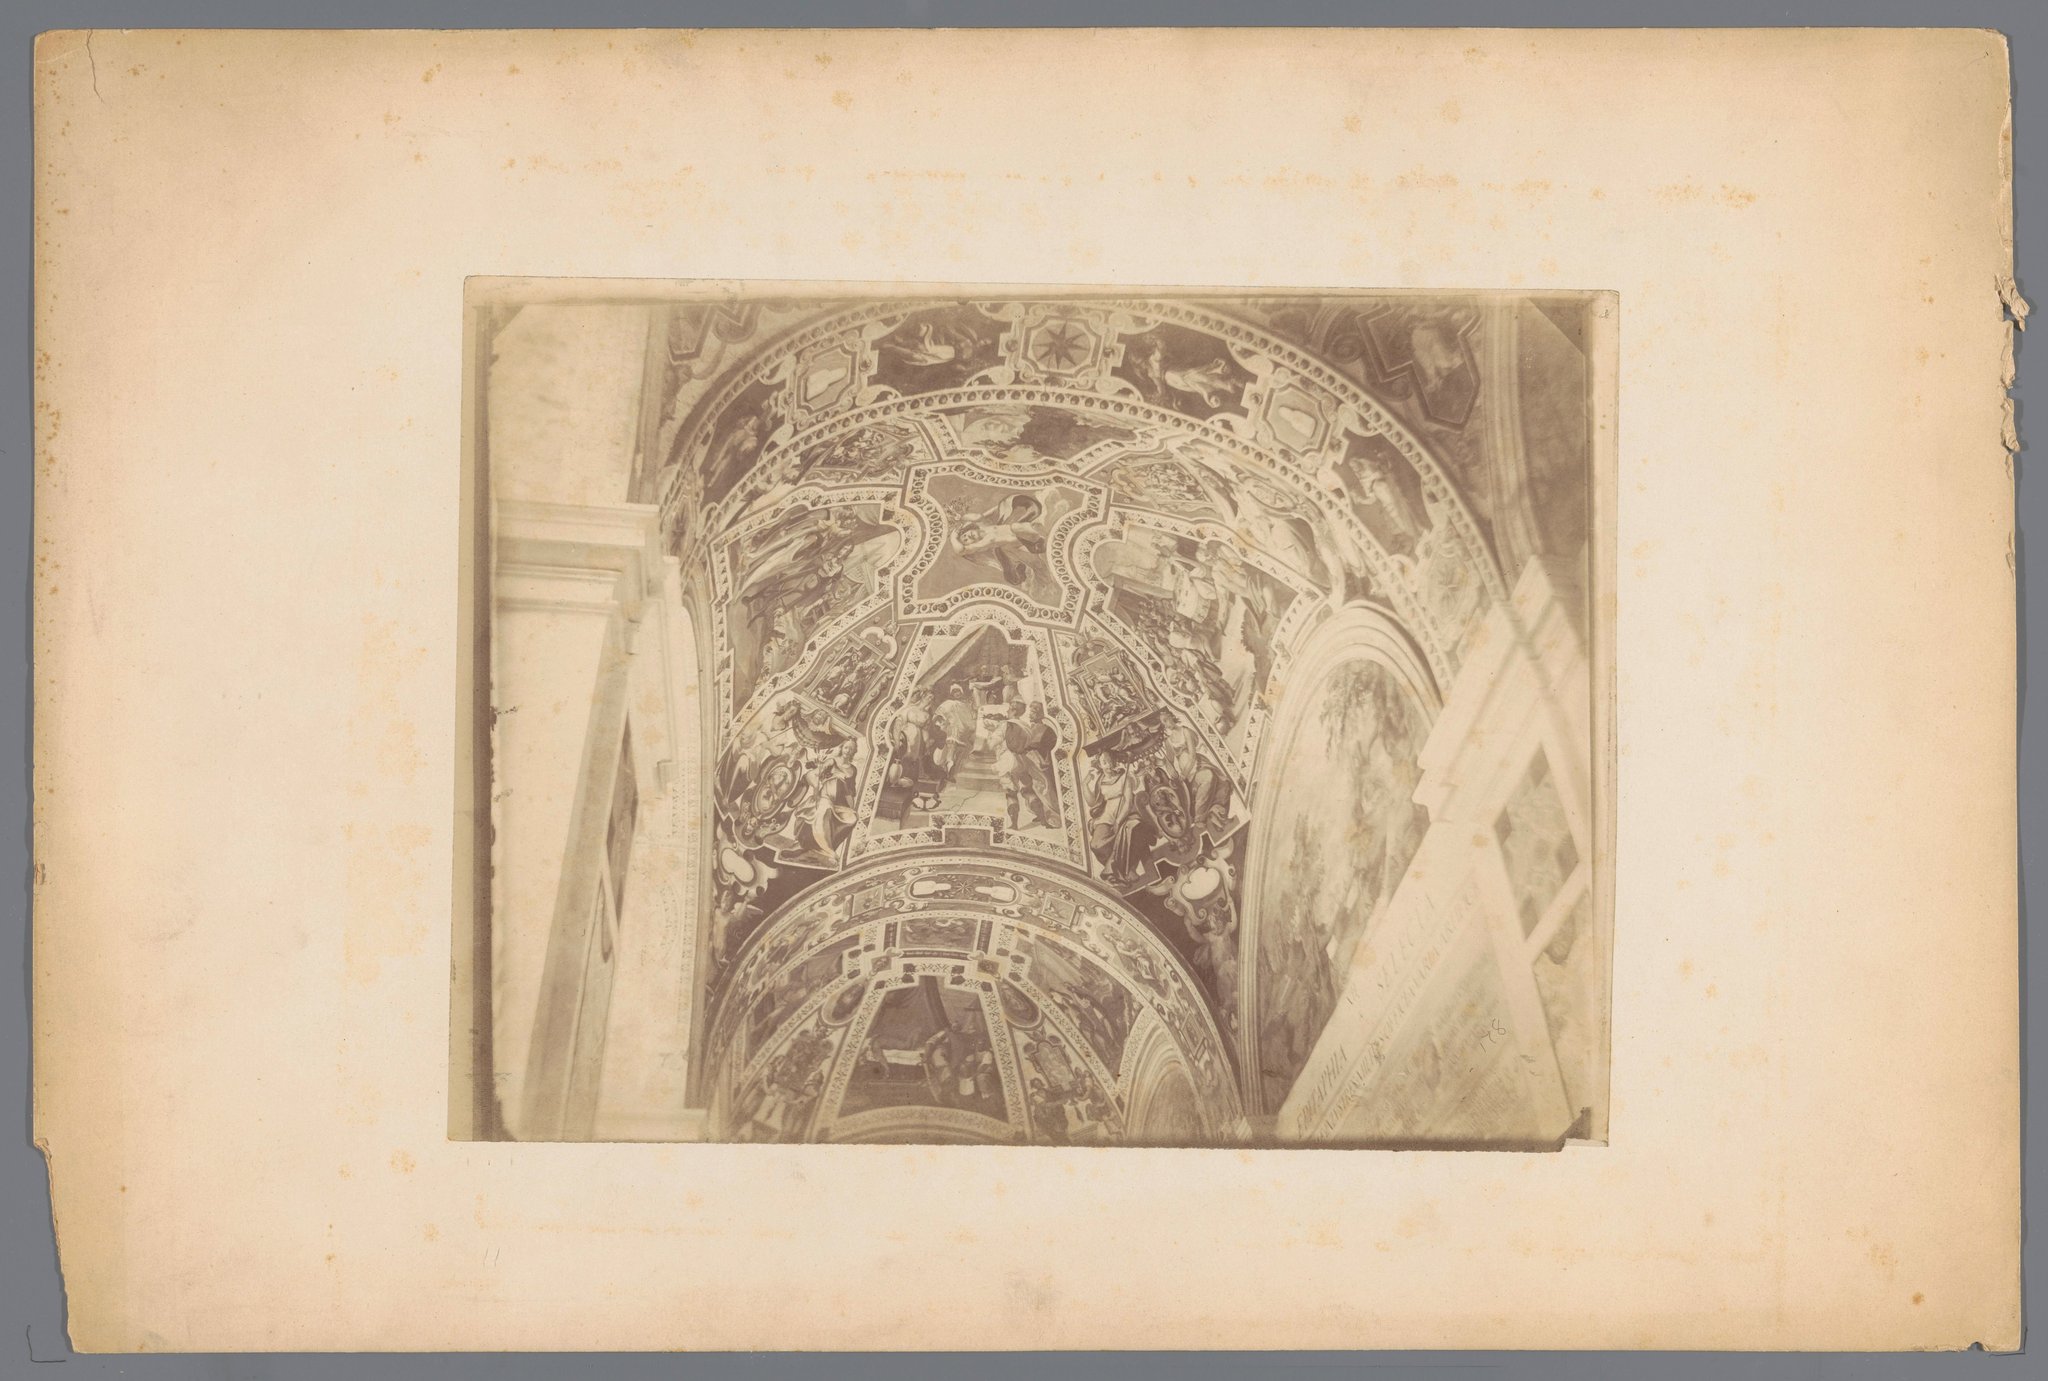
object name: photograph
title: Plafonschildering in de Vaticaanse Musea te Vaticaanstad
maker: gustave eugène chauffourier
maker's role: fotograaf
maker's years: 1845-1919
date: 1875-1900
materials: photographic support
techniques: albumen print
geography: vatican museums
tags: (decorated) ceiling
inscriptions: collector's mark: Lugt 3937, number: ‘178’